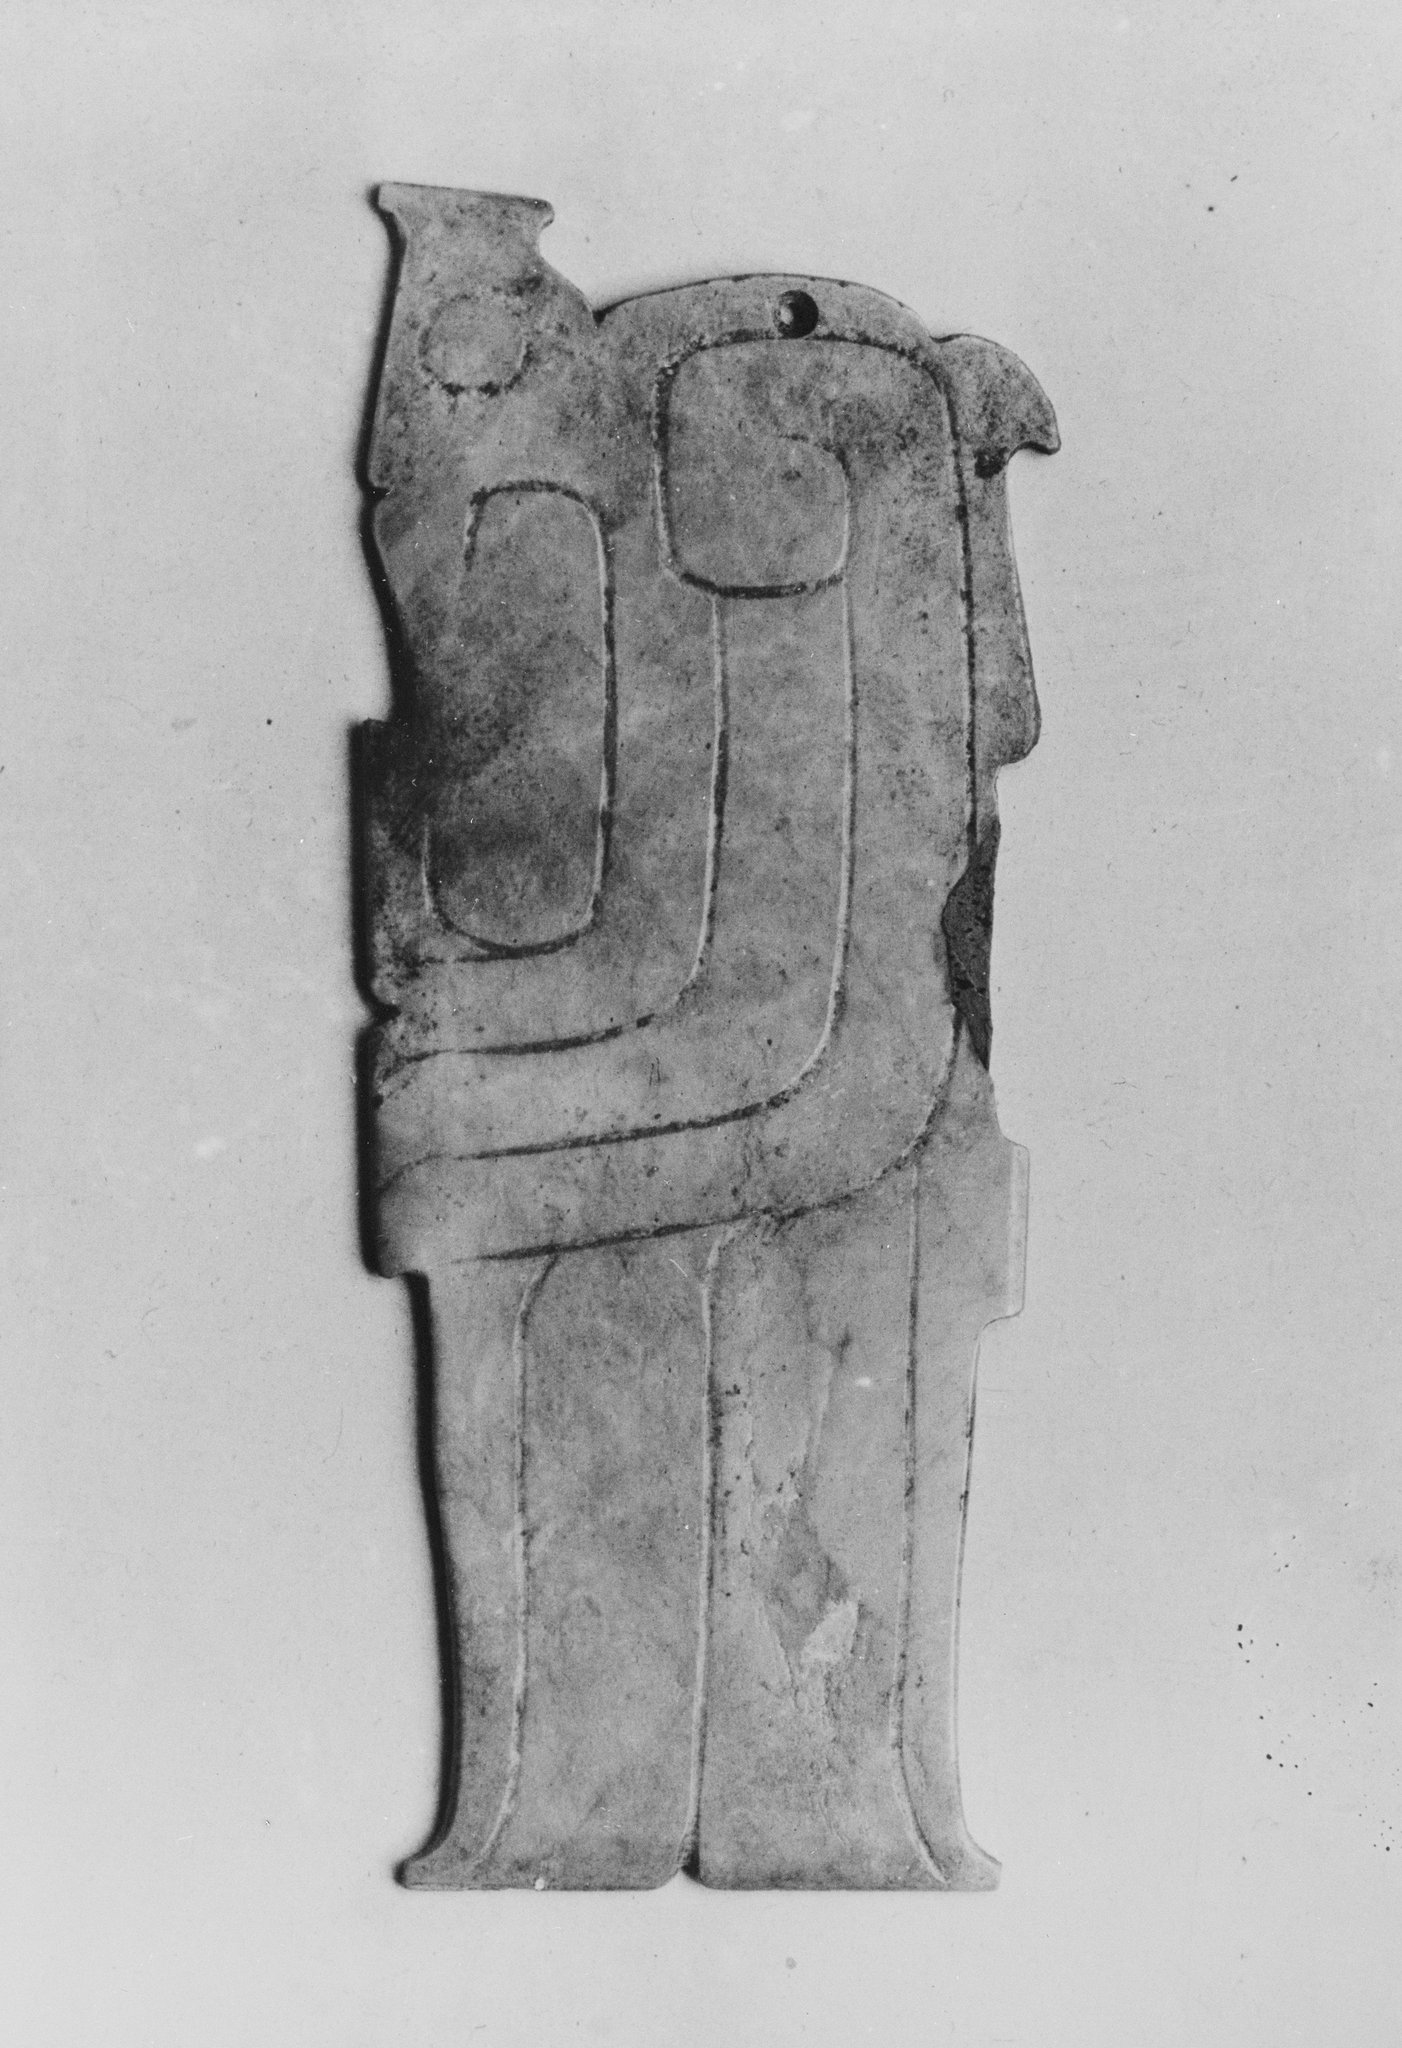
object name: plaque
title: Plaque in the shape of a fish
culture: chinese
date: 1100-901 BCE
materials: jade